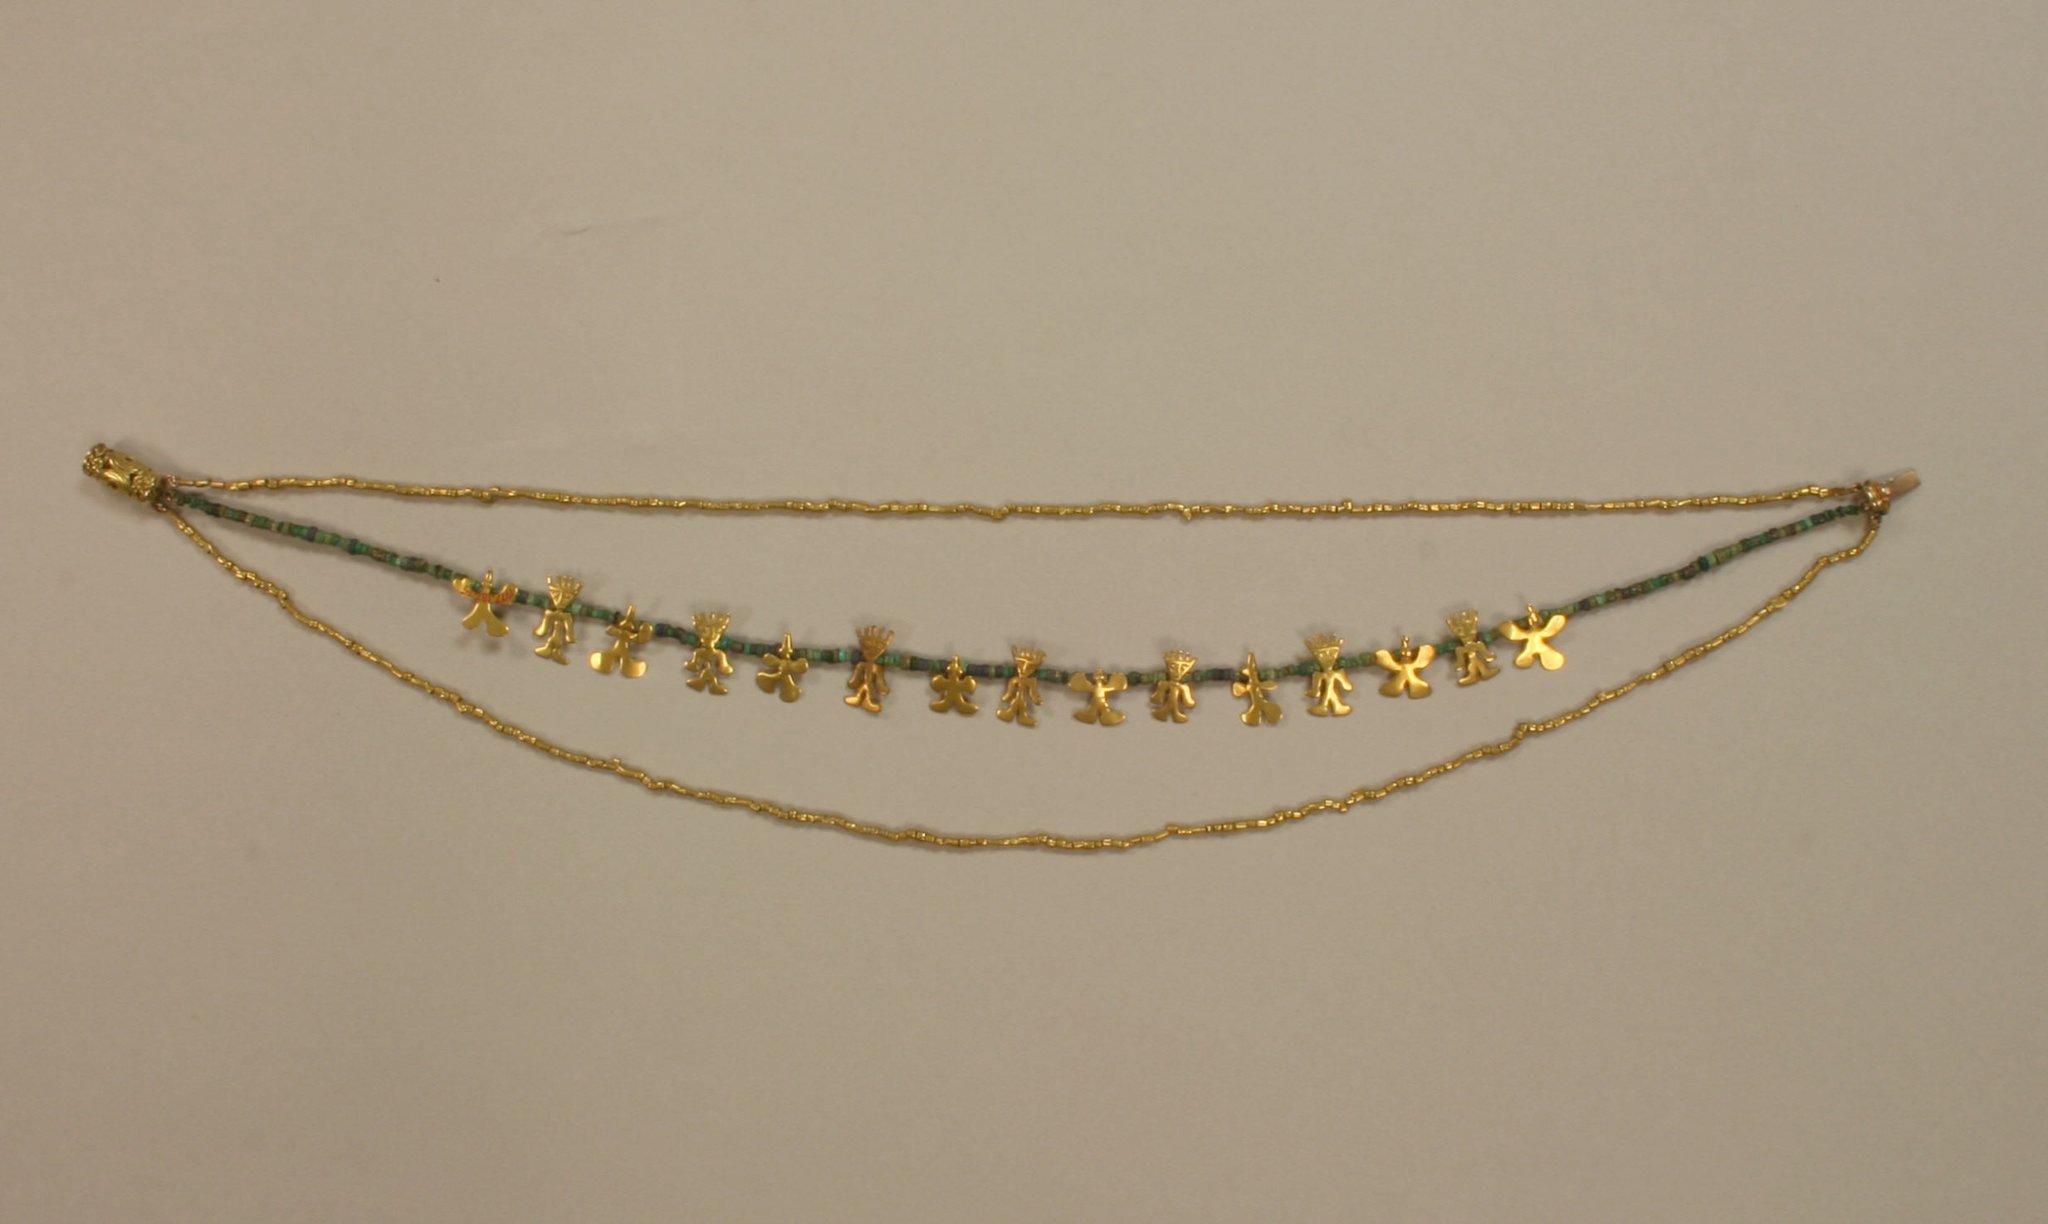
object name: necklace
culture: calima or yotoco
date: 1-700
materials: gold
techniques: casting, hammering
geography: colombia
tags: human figures